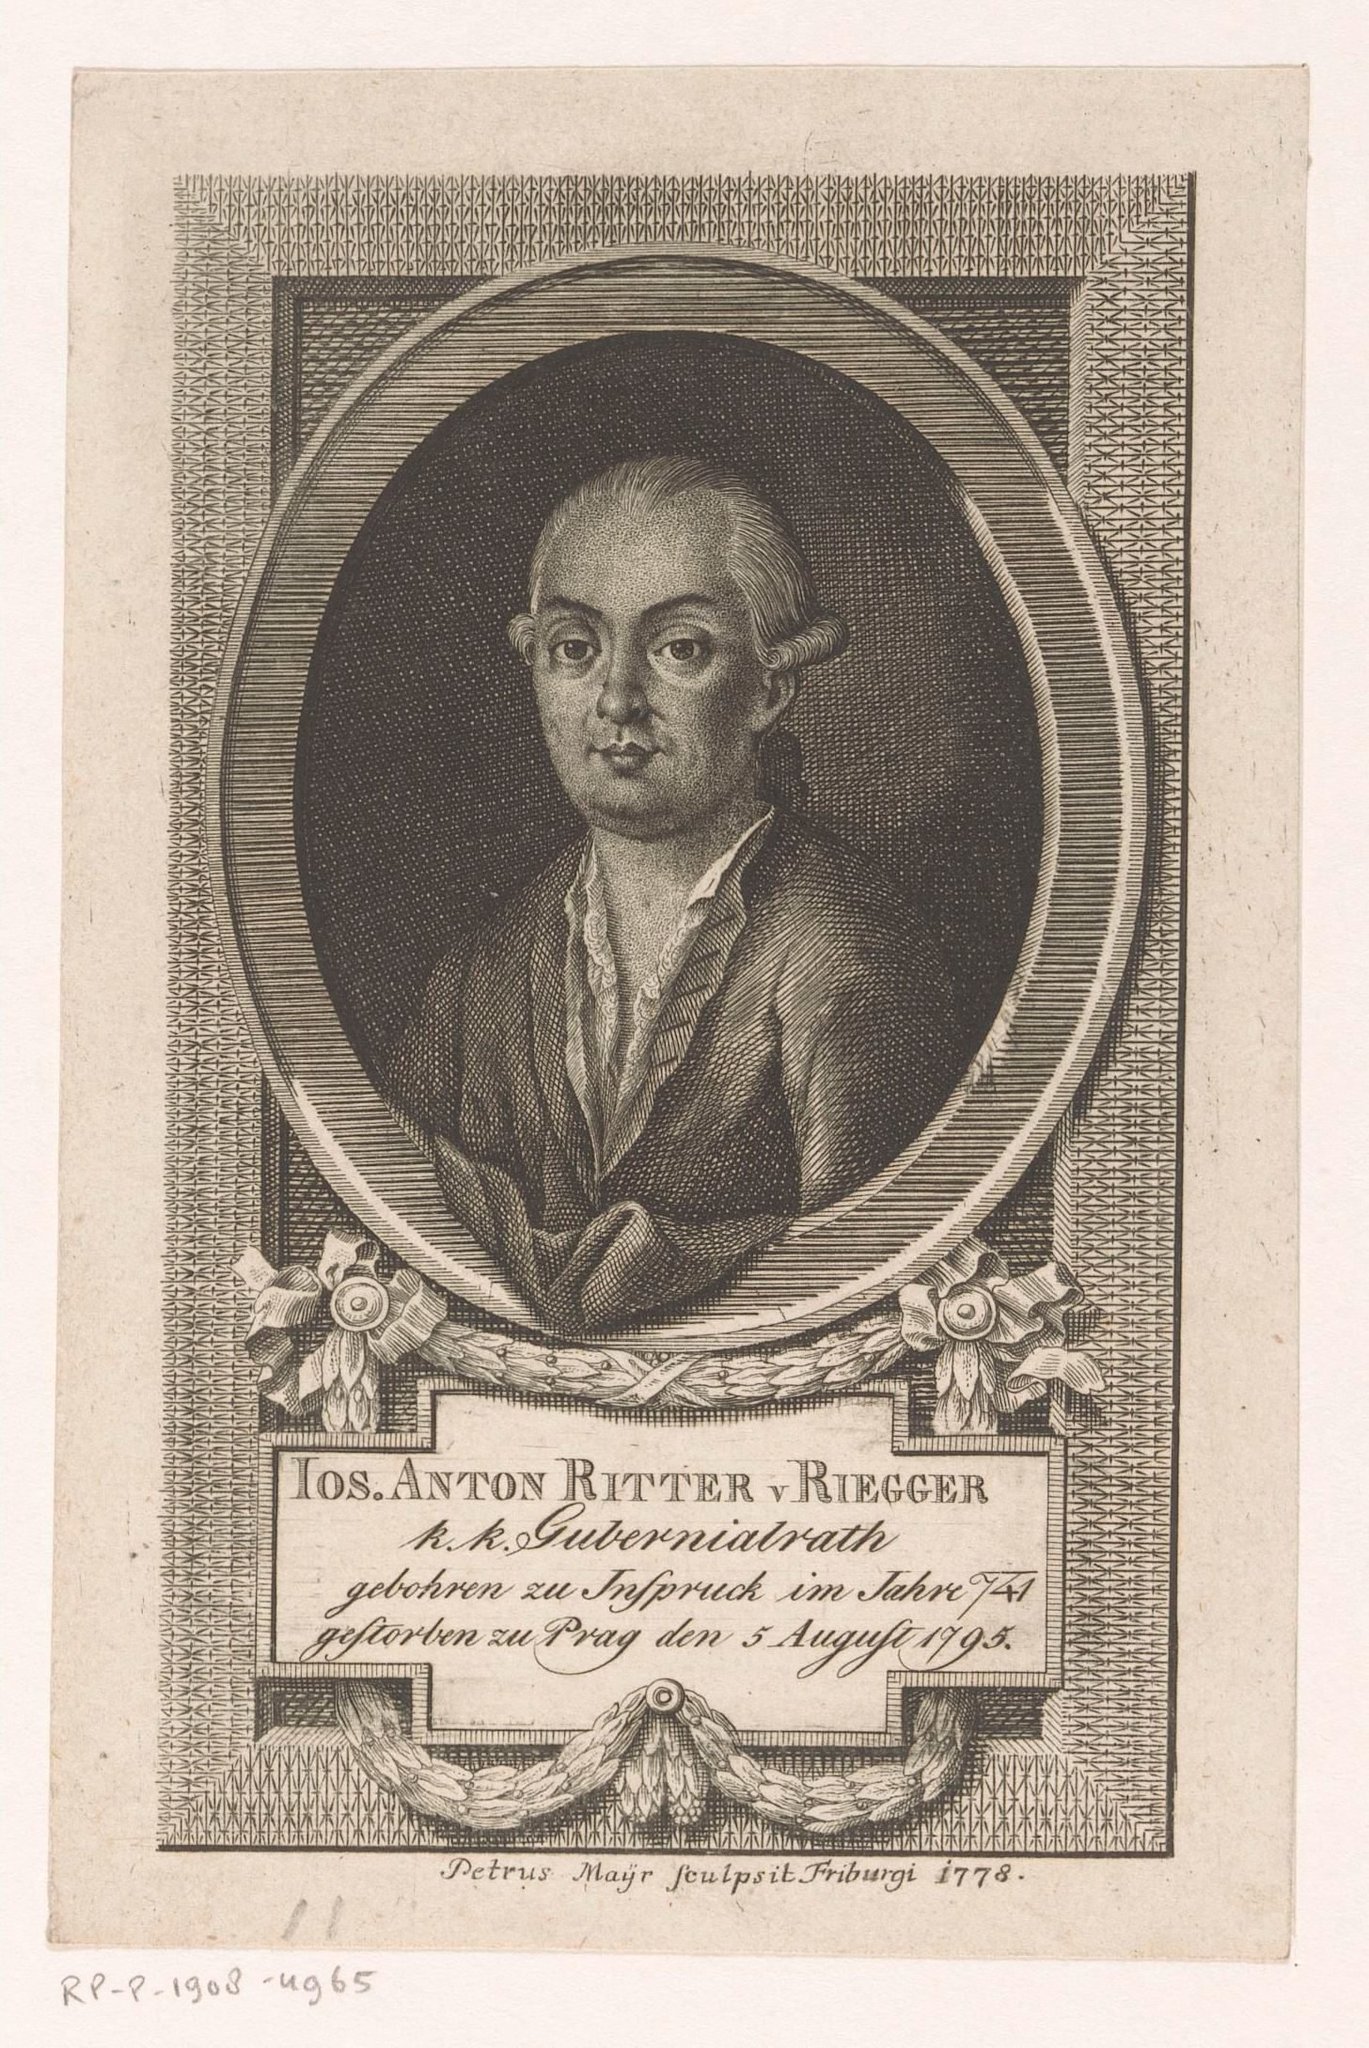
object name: print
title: Portret van Joseph Anton Stephan Riegger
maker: peter mayr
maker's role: painter, print maker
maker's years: 1758-1836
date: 1778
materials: paper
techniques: engraving, etching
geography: freiburg im breisgau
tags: prague, historical persons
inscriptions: collector's mark: Lugt 2228